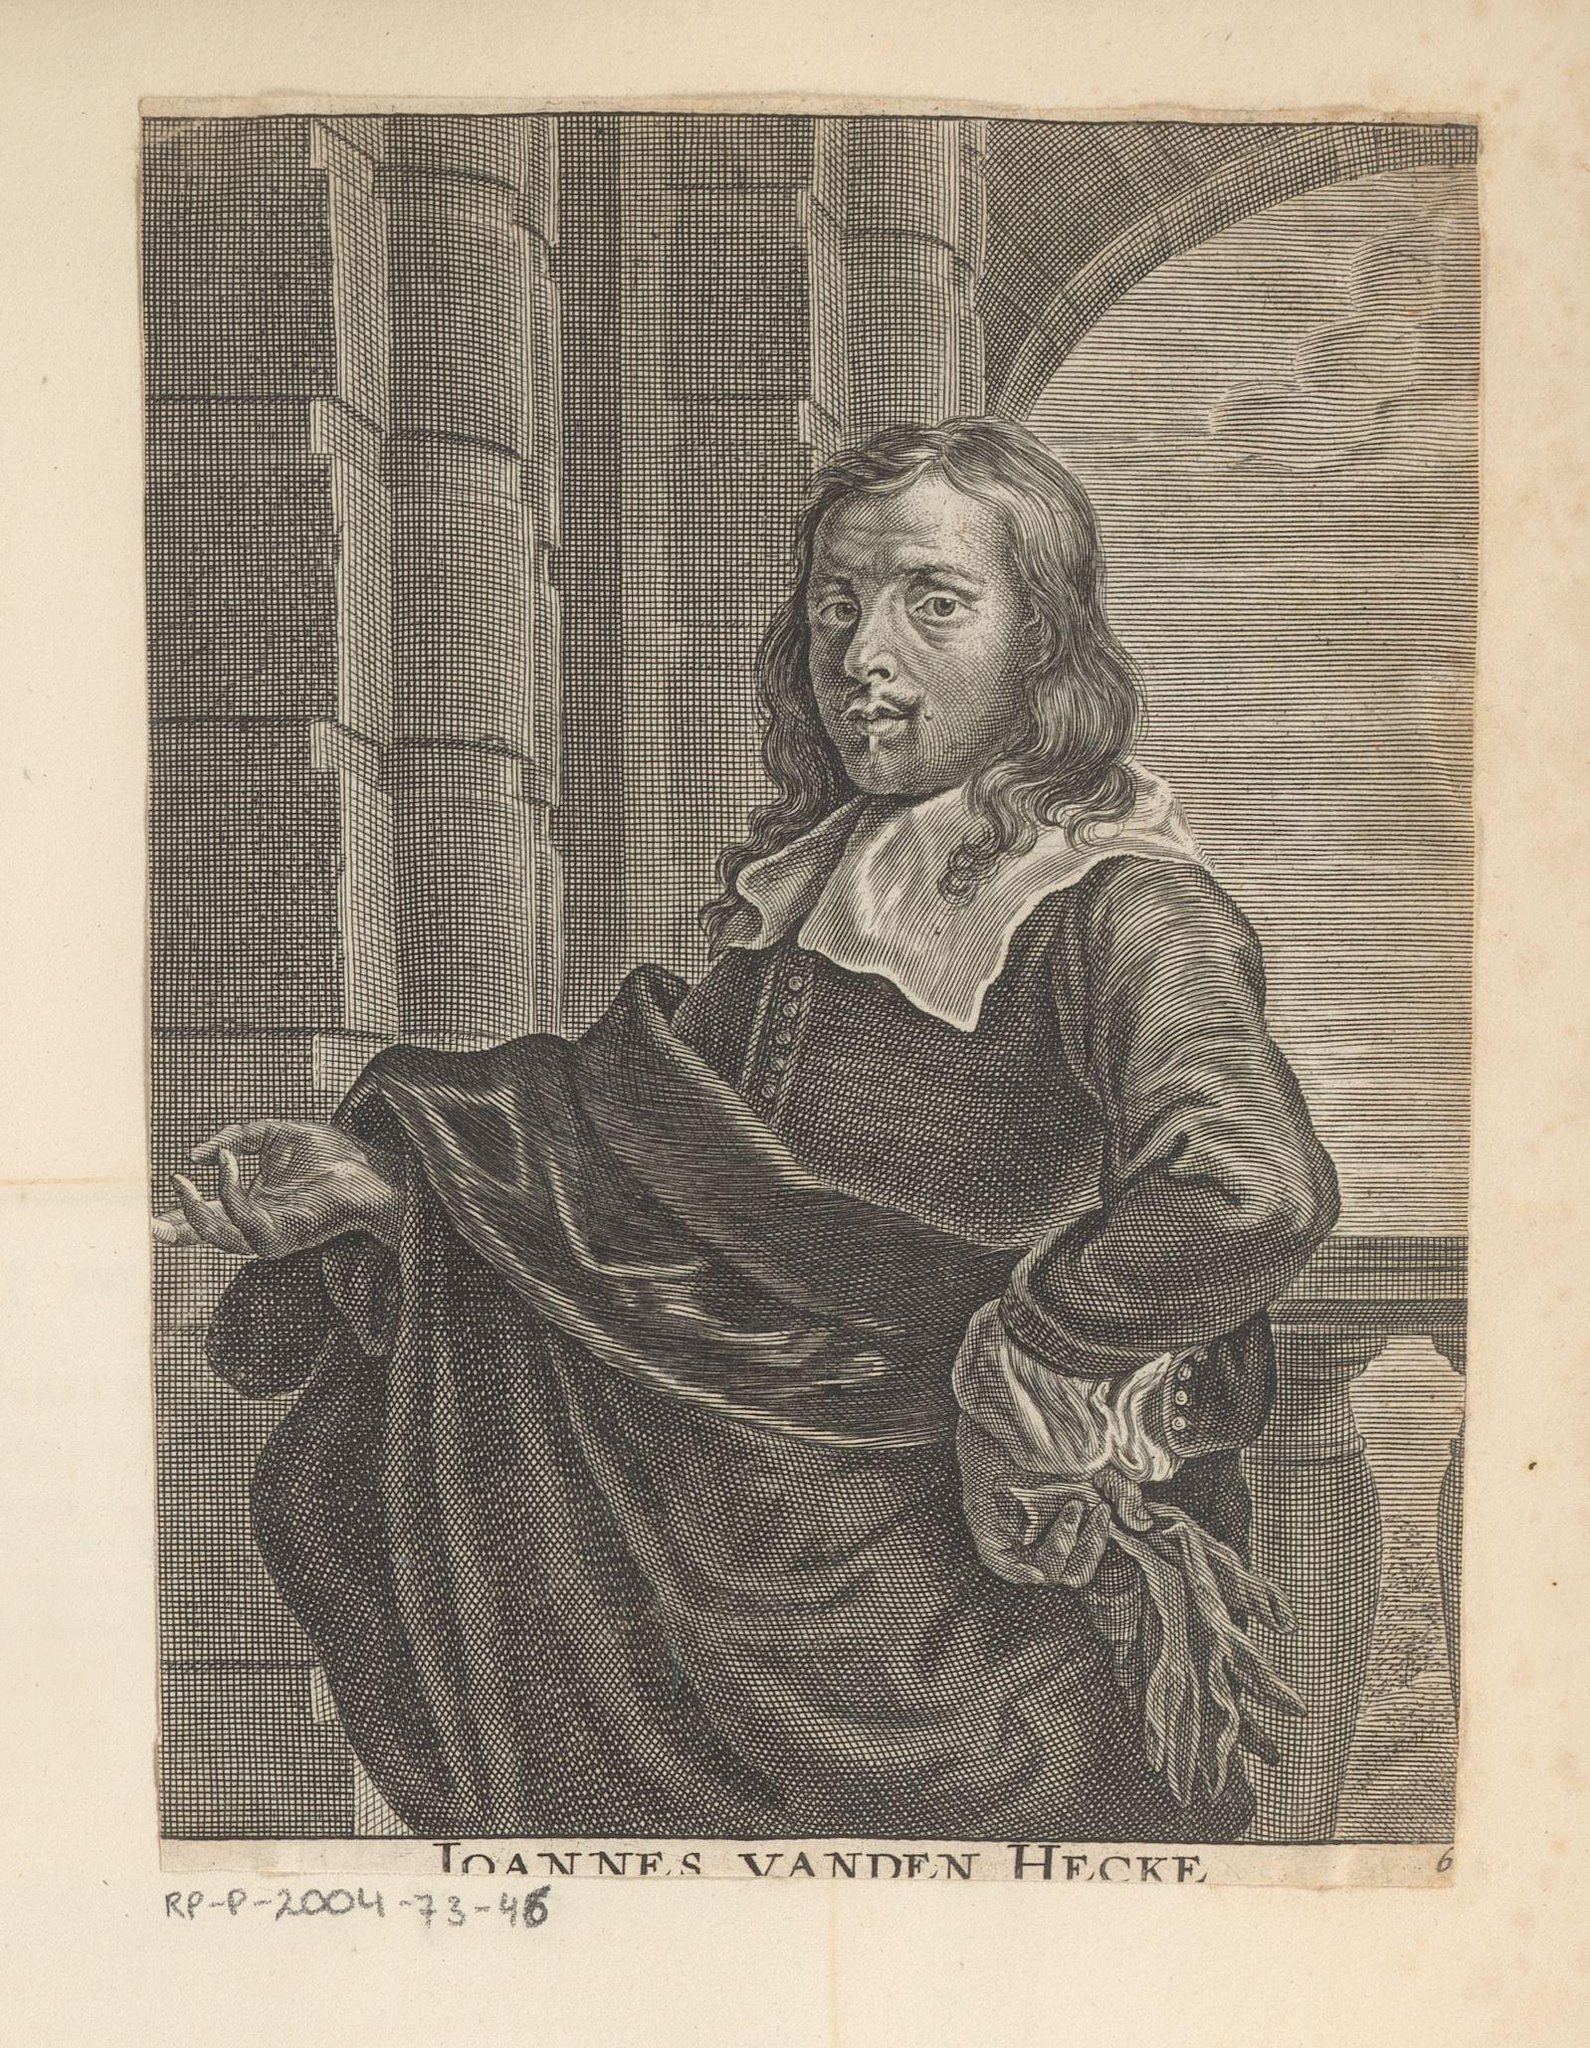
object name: book illustration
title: Joannes Vanden Hecke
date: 1649-1662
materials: paper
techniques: engraving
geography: antwerp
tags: antwerp, print maker, jan van den hecke (i), historical persons, portrait, self-portrait of painter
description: Prent mogelijk uit: Meyssens, Joannes. Image de divers hommes desprit sublime qui par leur art et science deburovent vivre eternellement et des quels la louange et renommée faict estonner le monde. Antwerpen: Joannes Meyssens, 1649, dl. 2, p. 20. Andere staat van prent gebruikt in: Bie, Cornelis De. Het gulden Cabinet vande edel vry schilder const, inhoudende den lof vande vermarste schilders, architecte, beldthowers ende plaetsnyders van dese eeuw. Antwerpen: Joannes Meyssens, 1662 [1661 foutief op titelpagina], p. 365. De samensteller heeft deze prent in het album geplakt als illustratie bij: Pilkington, Matthew en Johann Heinrich Füssli. A dictionary of painters, from the revival of the art to the present period. 4 dln. Londen: John Crowder, 1805, dl. 2, p. 236.